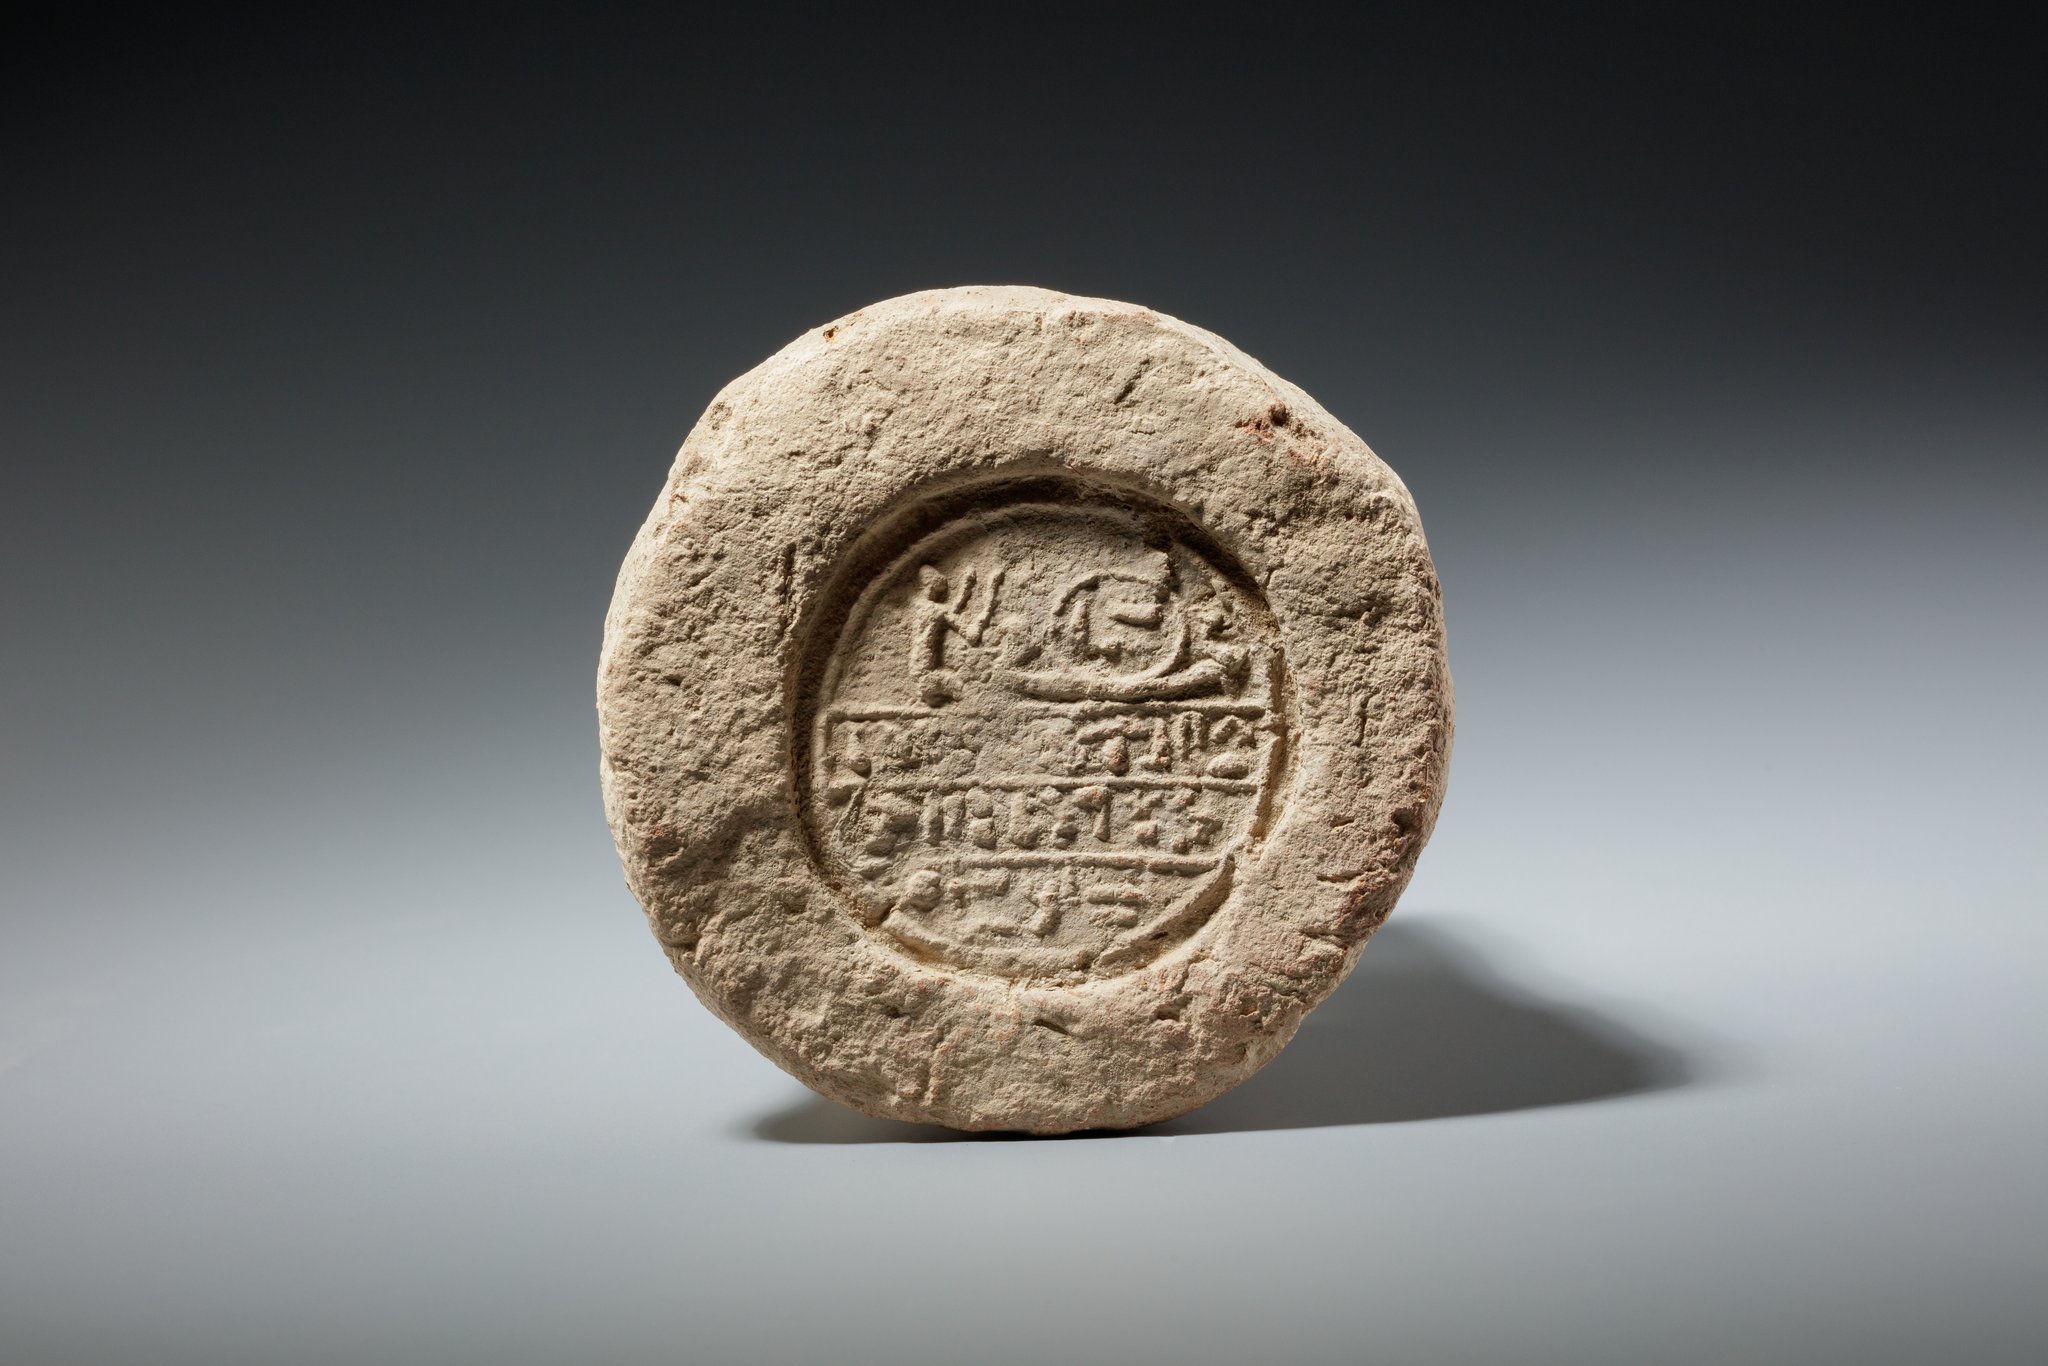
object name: cone, davy 585, khaempashemes, butler, divine adoratrice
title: Funerary Cone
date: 1550-1295 BCE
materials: pottery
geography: egypt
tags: hieroglyphs